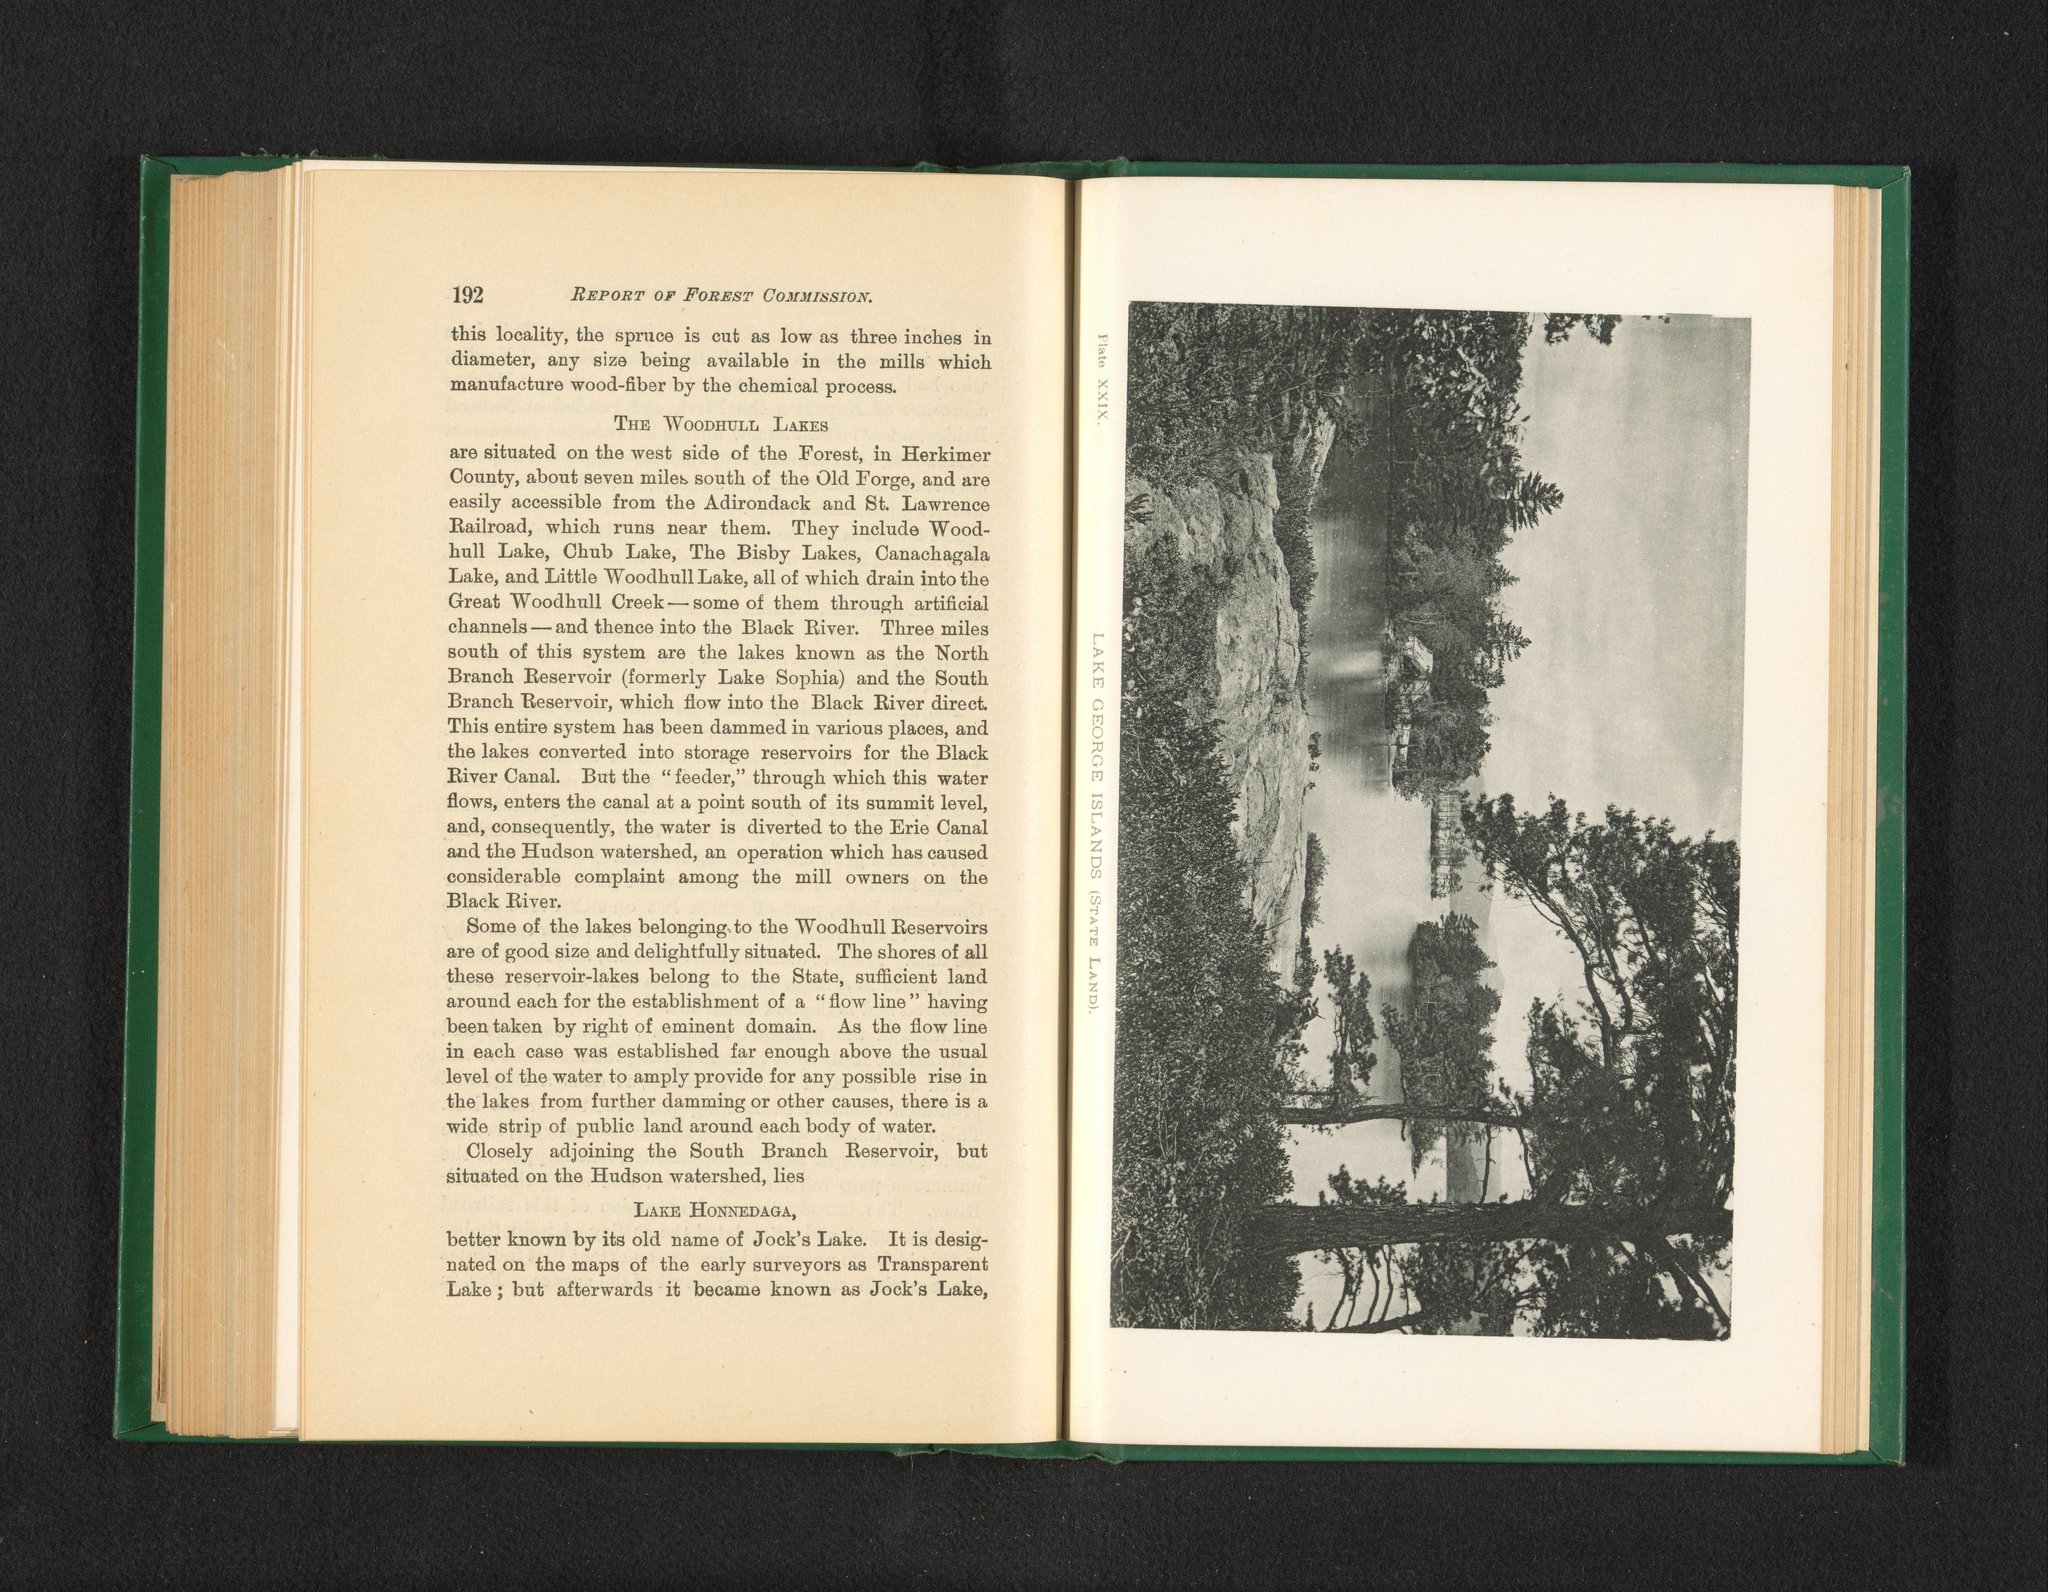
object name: page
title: Lake George Islands (State land)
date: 1891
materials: paper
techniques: photograph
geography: new york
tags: lake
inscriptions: number: ‘Plate XXIX.’